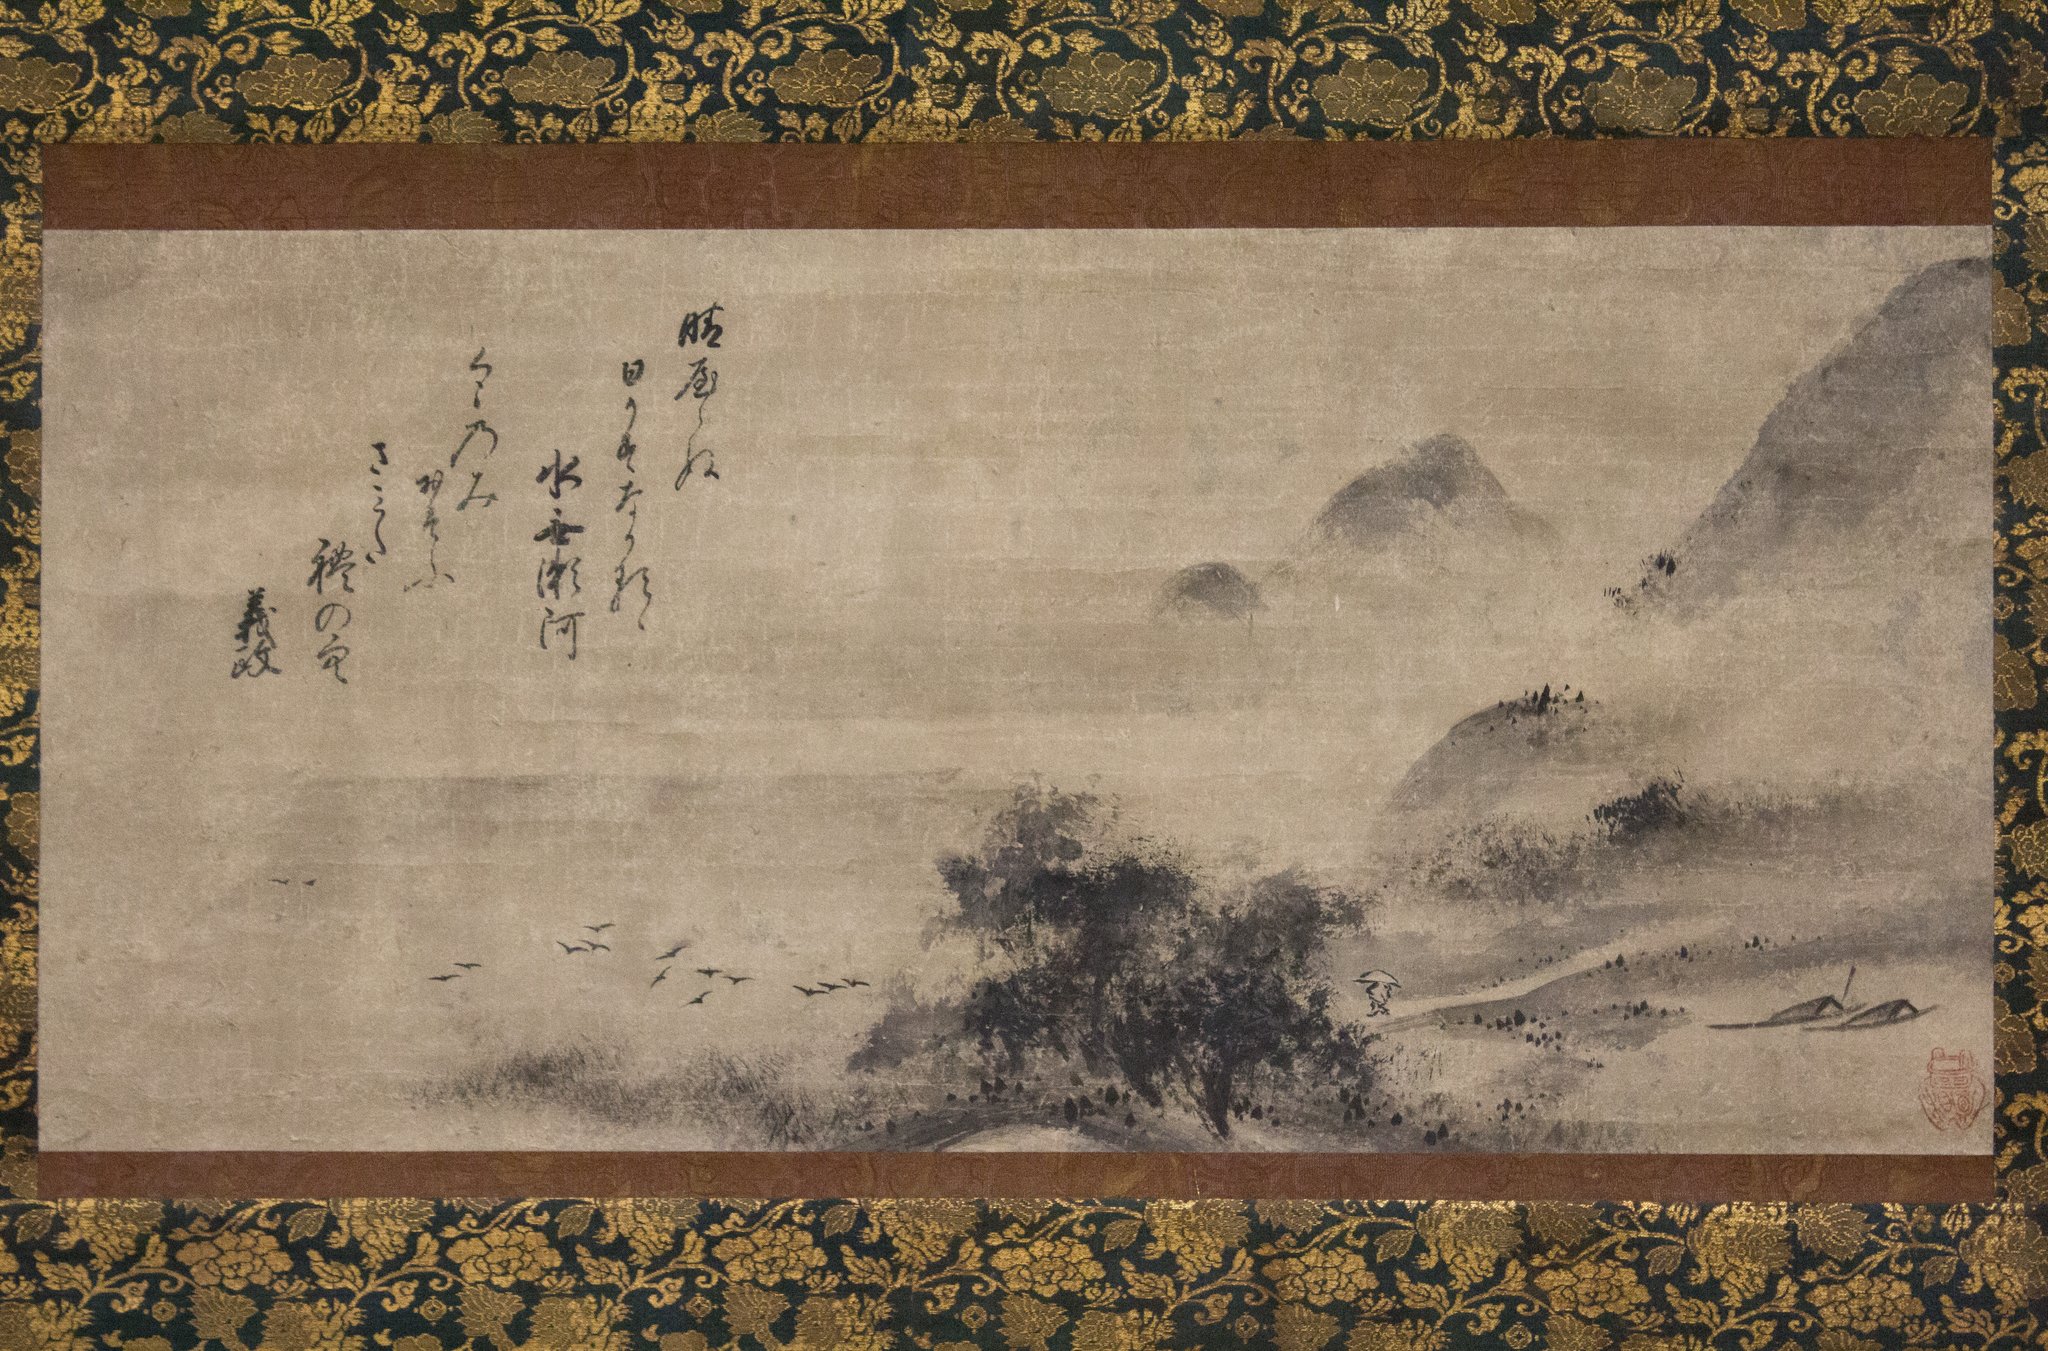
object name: hanging scroll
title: Rainy Landscape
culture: japanese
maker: sōami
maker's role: artist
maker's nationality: japanese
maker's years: 1485-1525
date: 1601-1700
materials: ink, paper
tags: mountains,landscapes